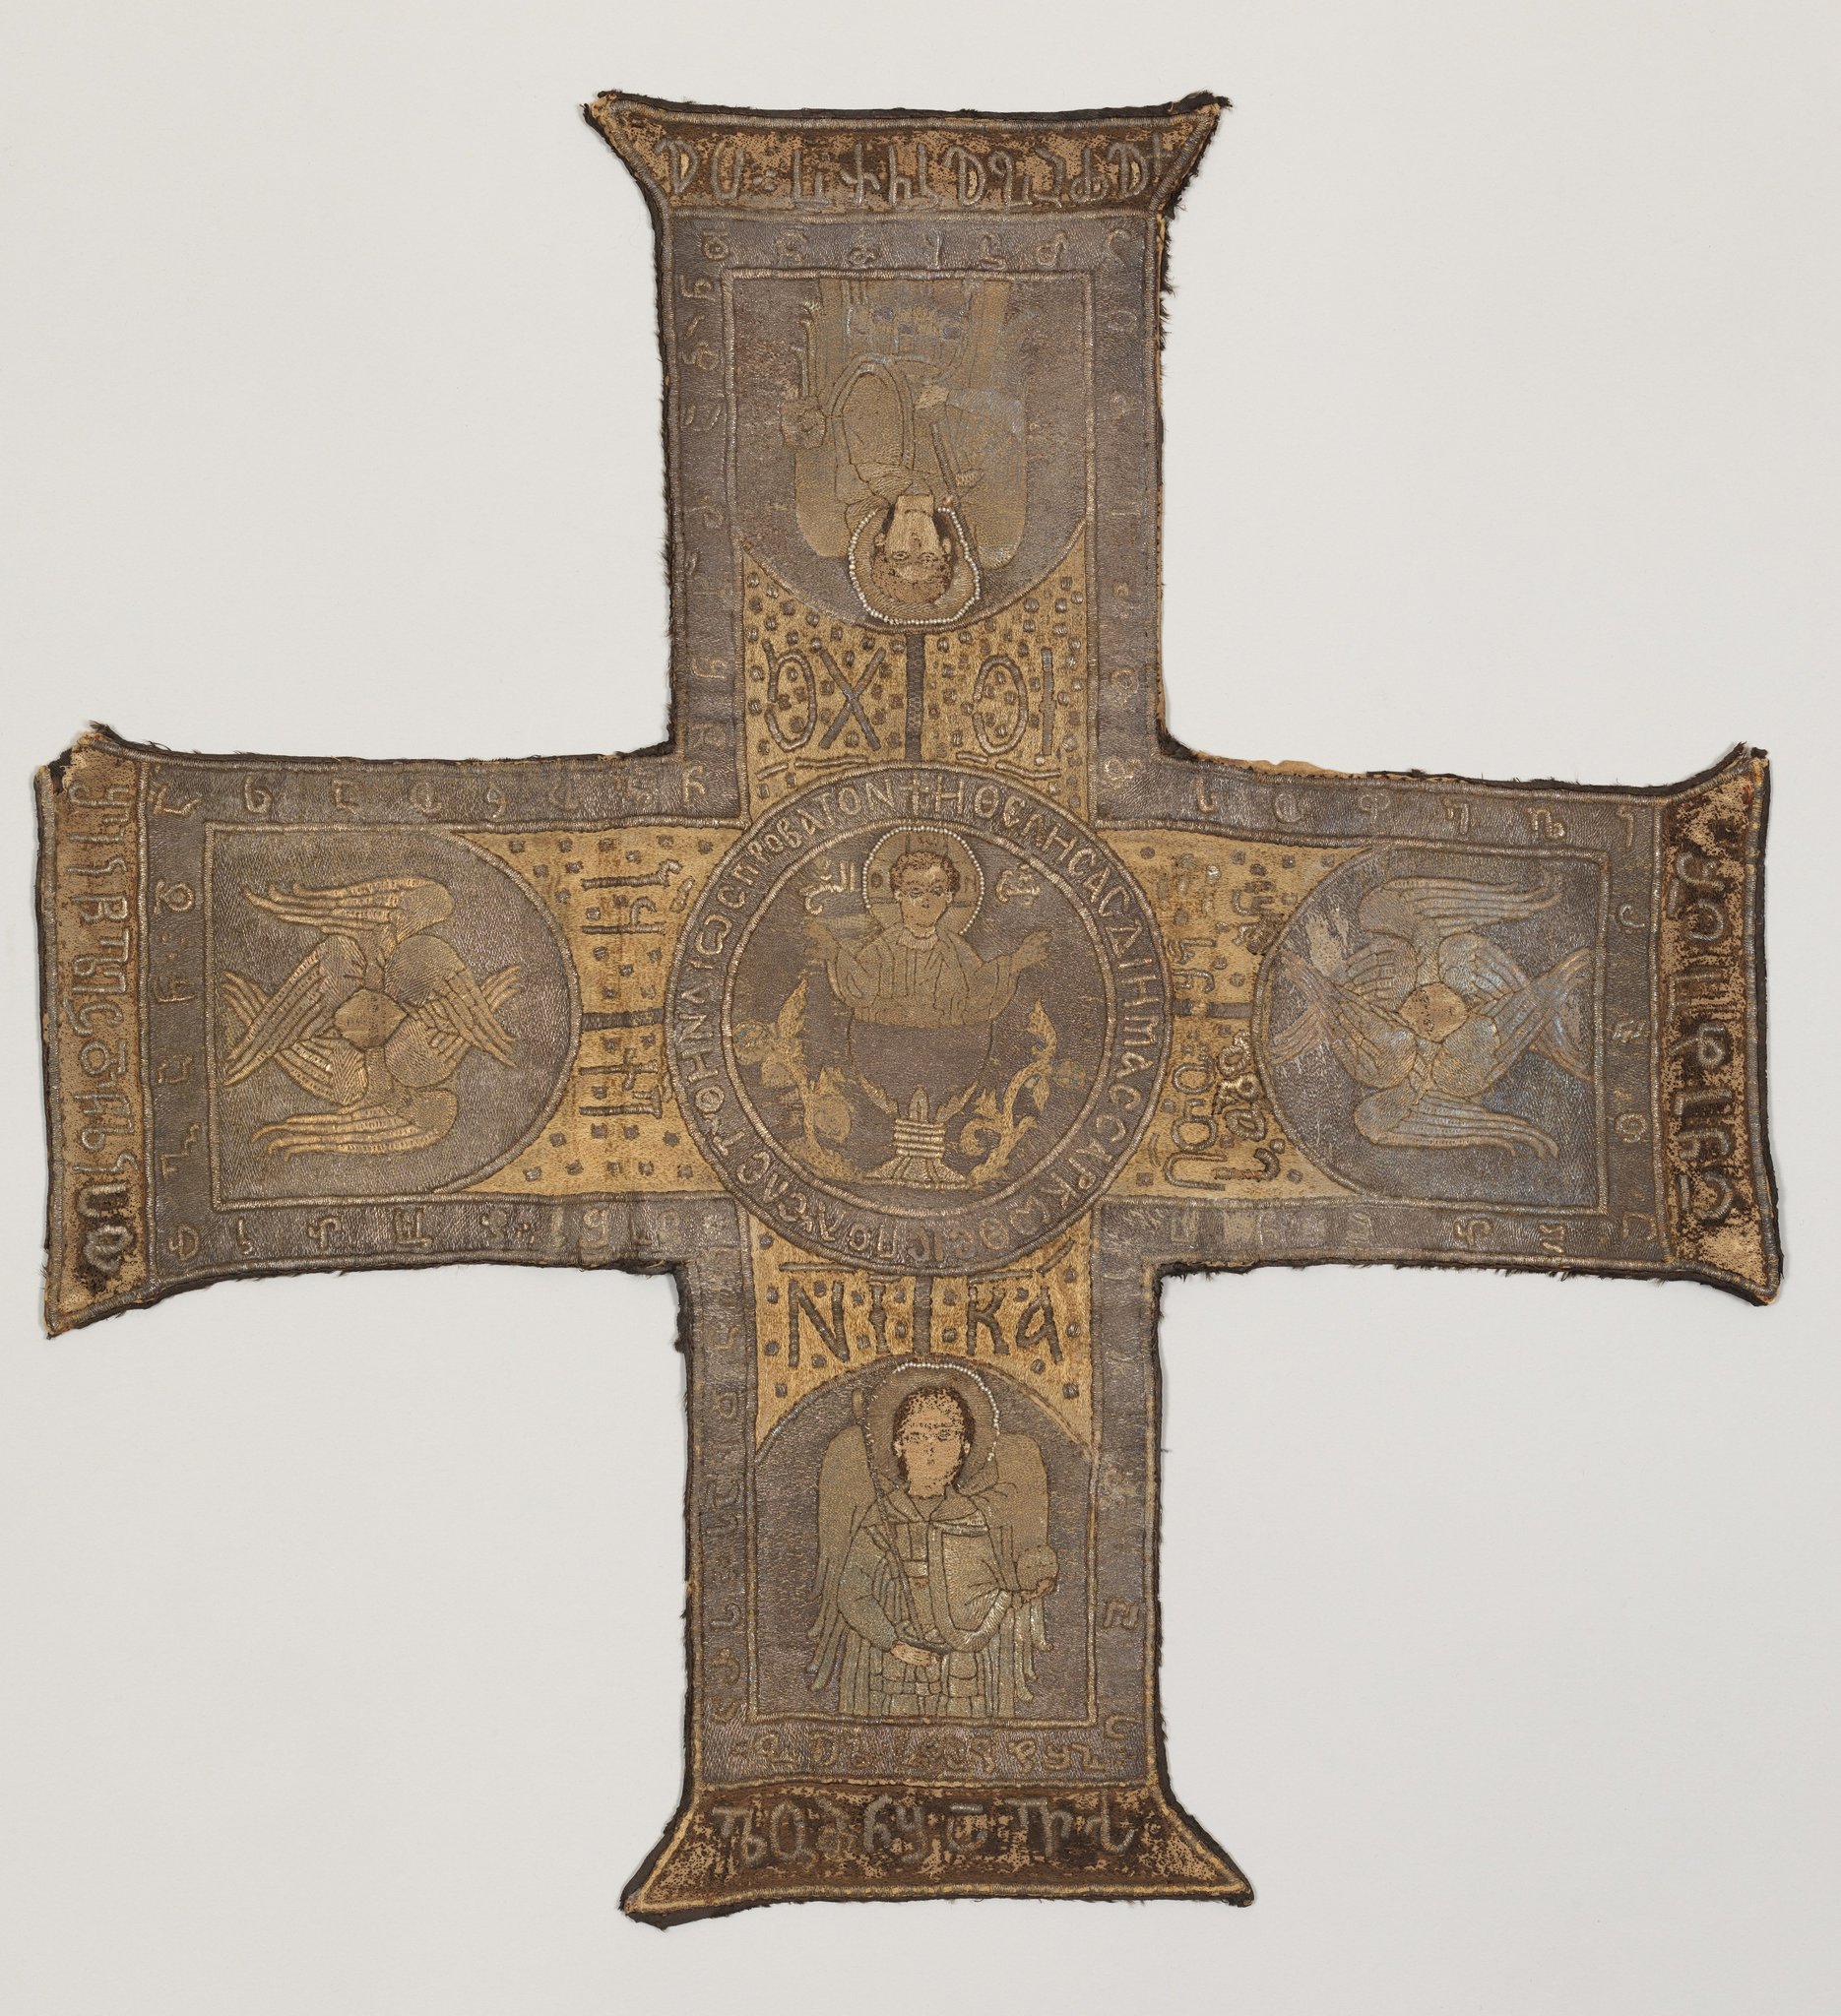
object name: chalice cover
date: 1467-1500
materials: linen, metal thread, silk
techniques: backing, embroidery, weave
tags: angels,christ,cross